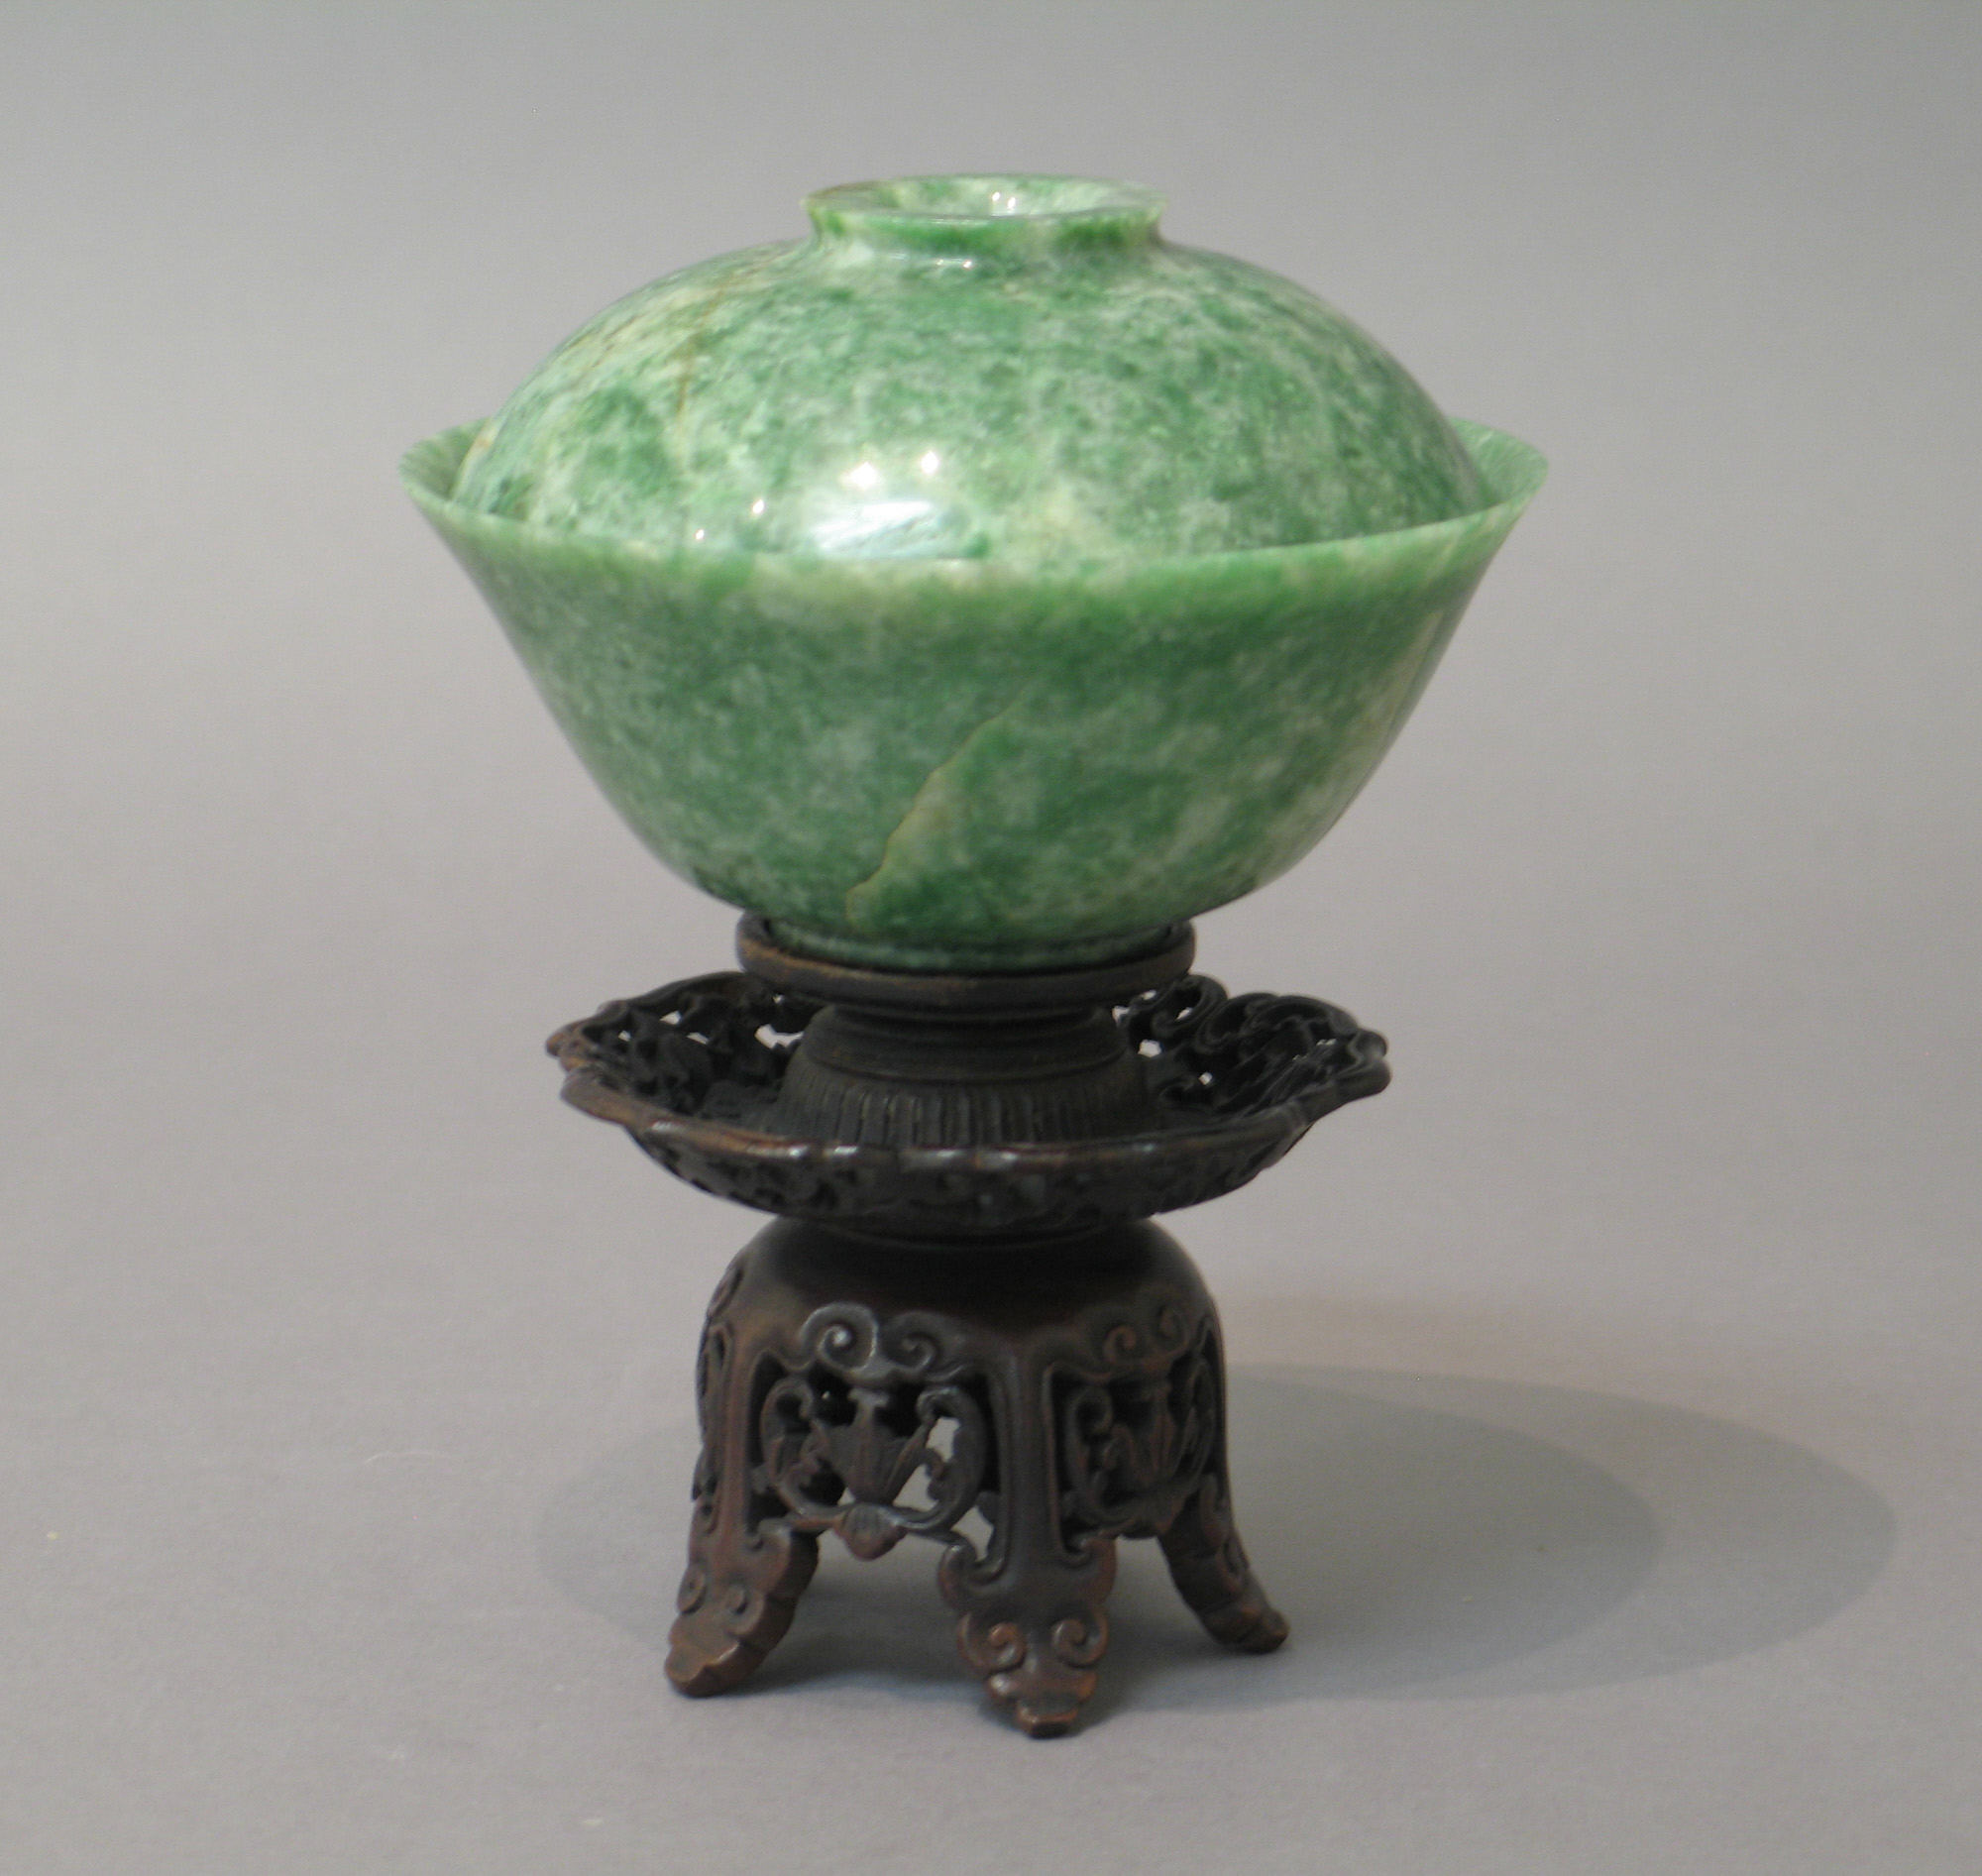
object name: cup with cover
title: Cup and cover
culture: chinese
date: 1796-1875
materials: jade